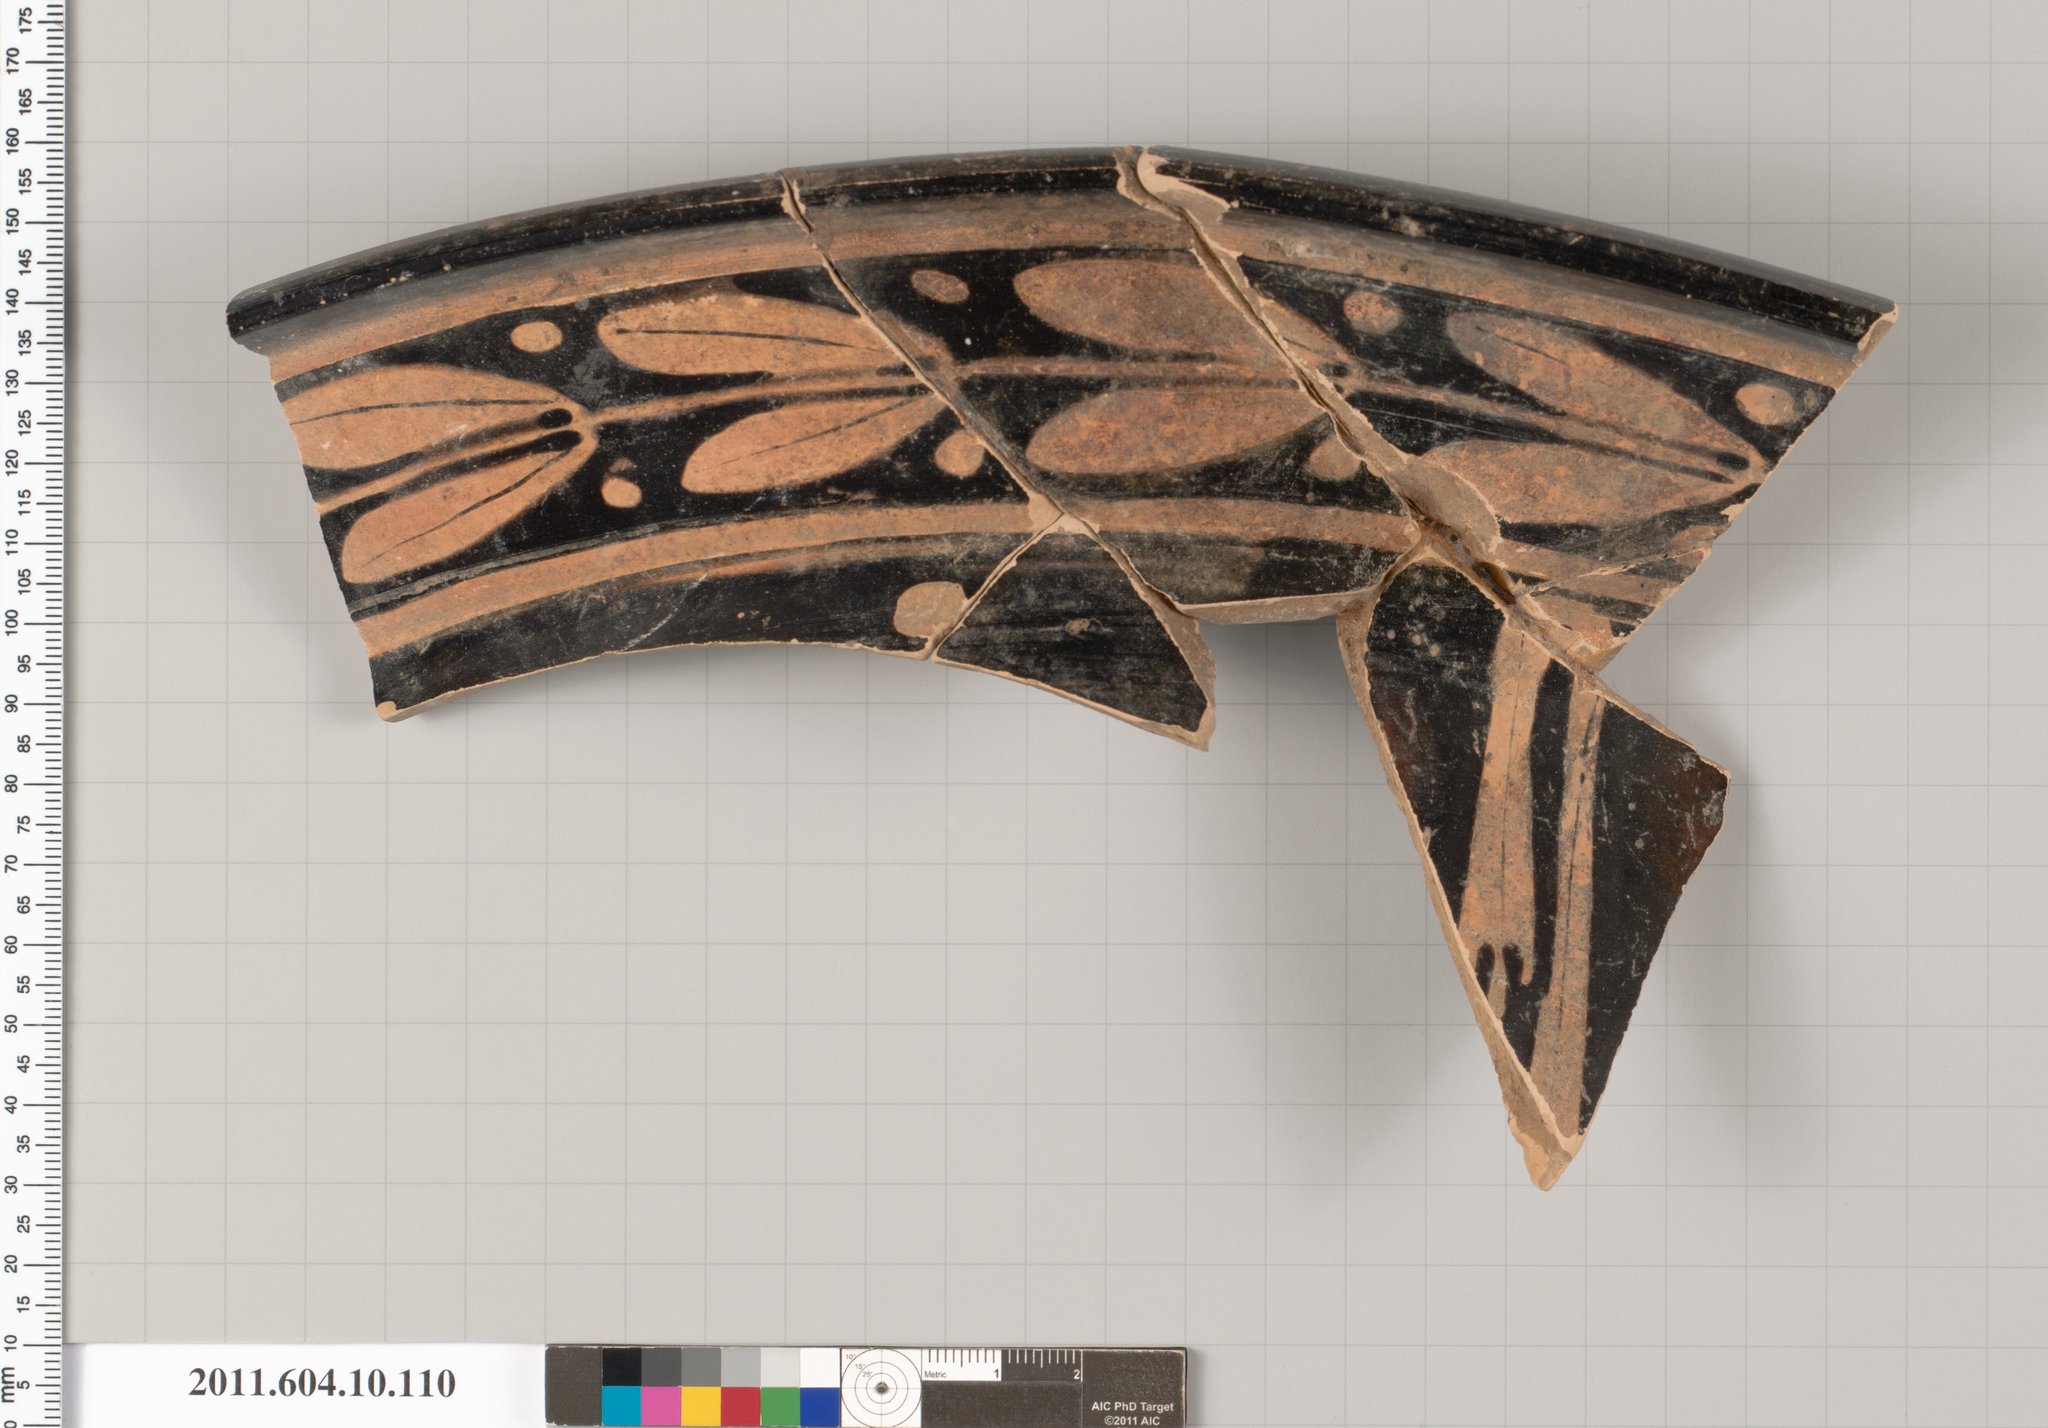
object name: krater fragment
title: Terracotta fragment of a bell-krater (deep bowl)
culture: etruscan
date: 434-368 BCE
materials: terracotta